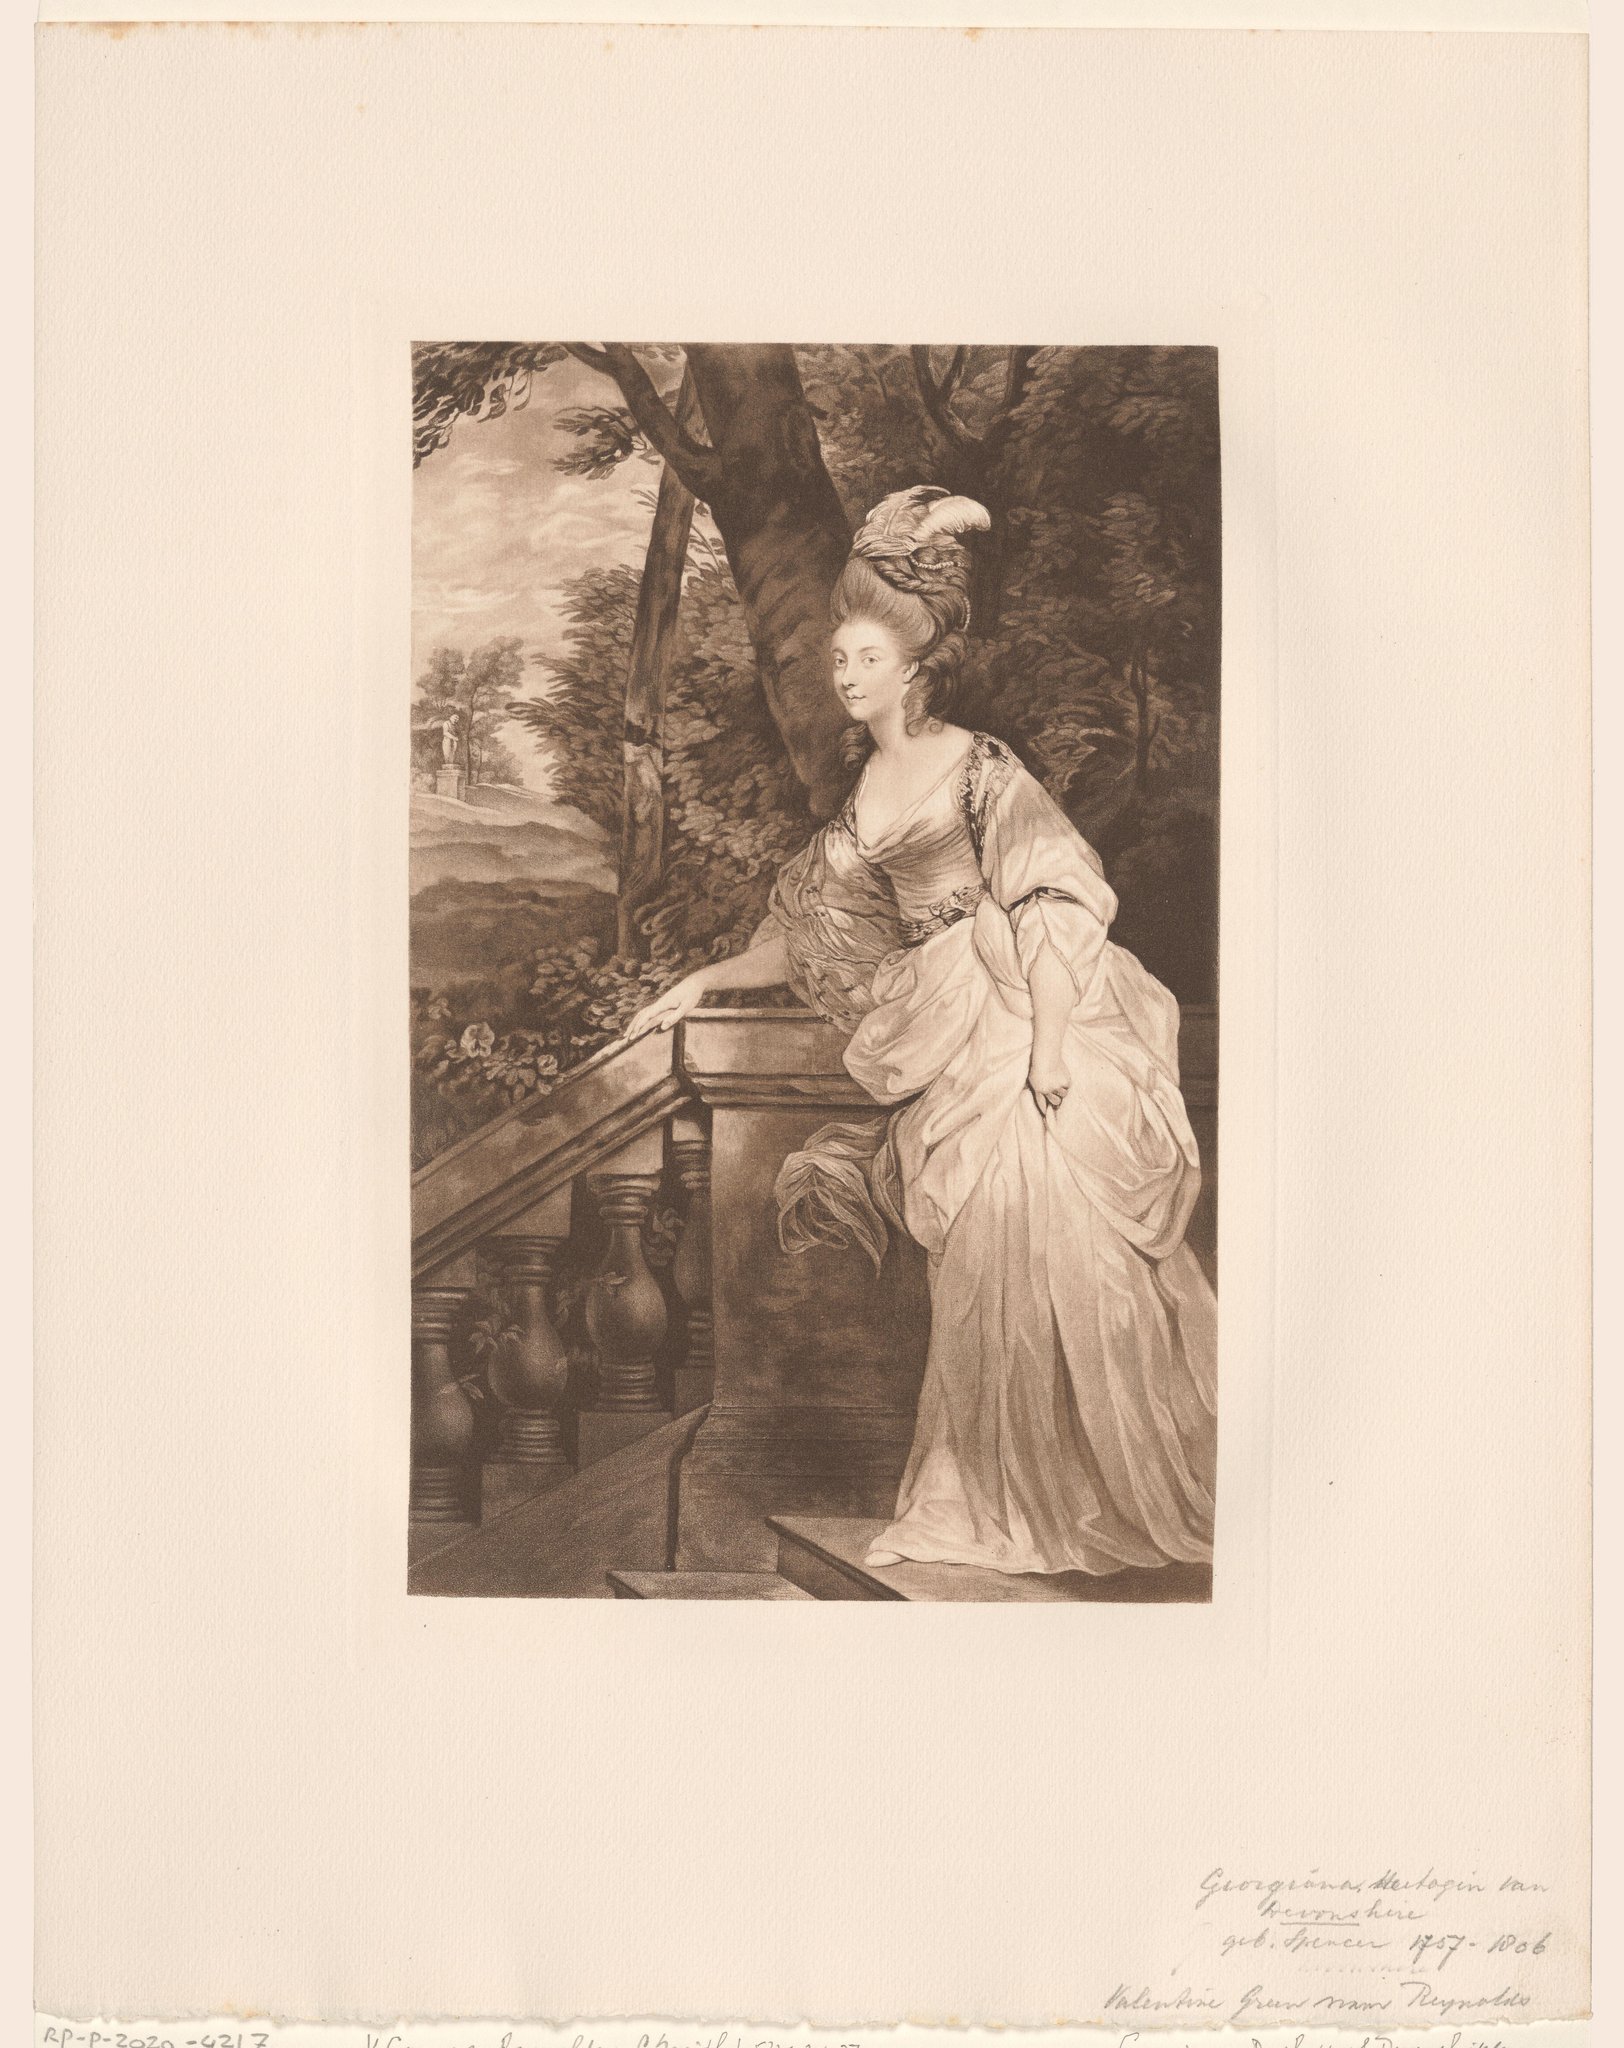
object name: photomechanical print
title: Portret van Georgiana Spencer, hertogin van Devonshire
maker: Anonymous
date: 1870-1920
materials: paper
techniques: photoaquatint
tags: london, georgiana spencer (hertogin van devonshire), historical persons - bb - woman, garden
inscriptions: collector's mark: Lugt 2228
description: Staand in een tuin met haar rechterhand op de balustrade van een trap.